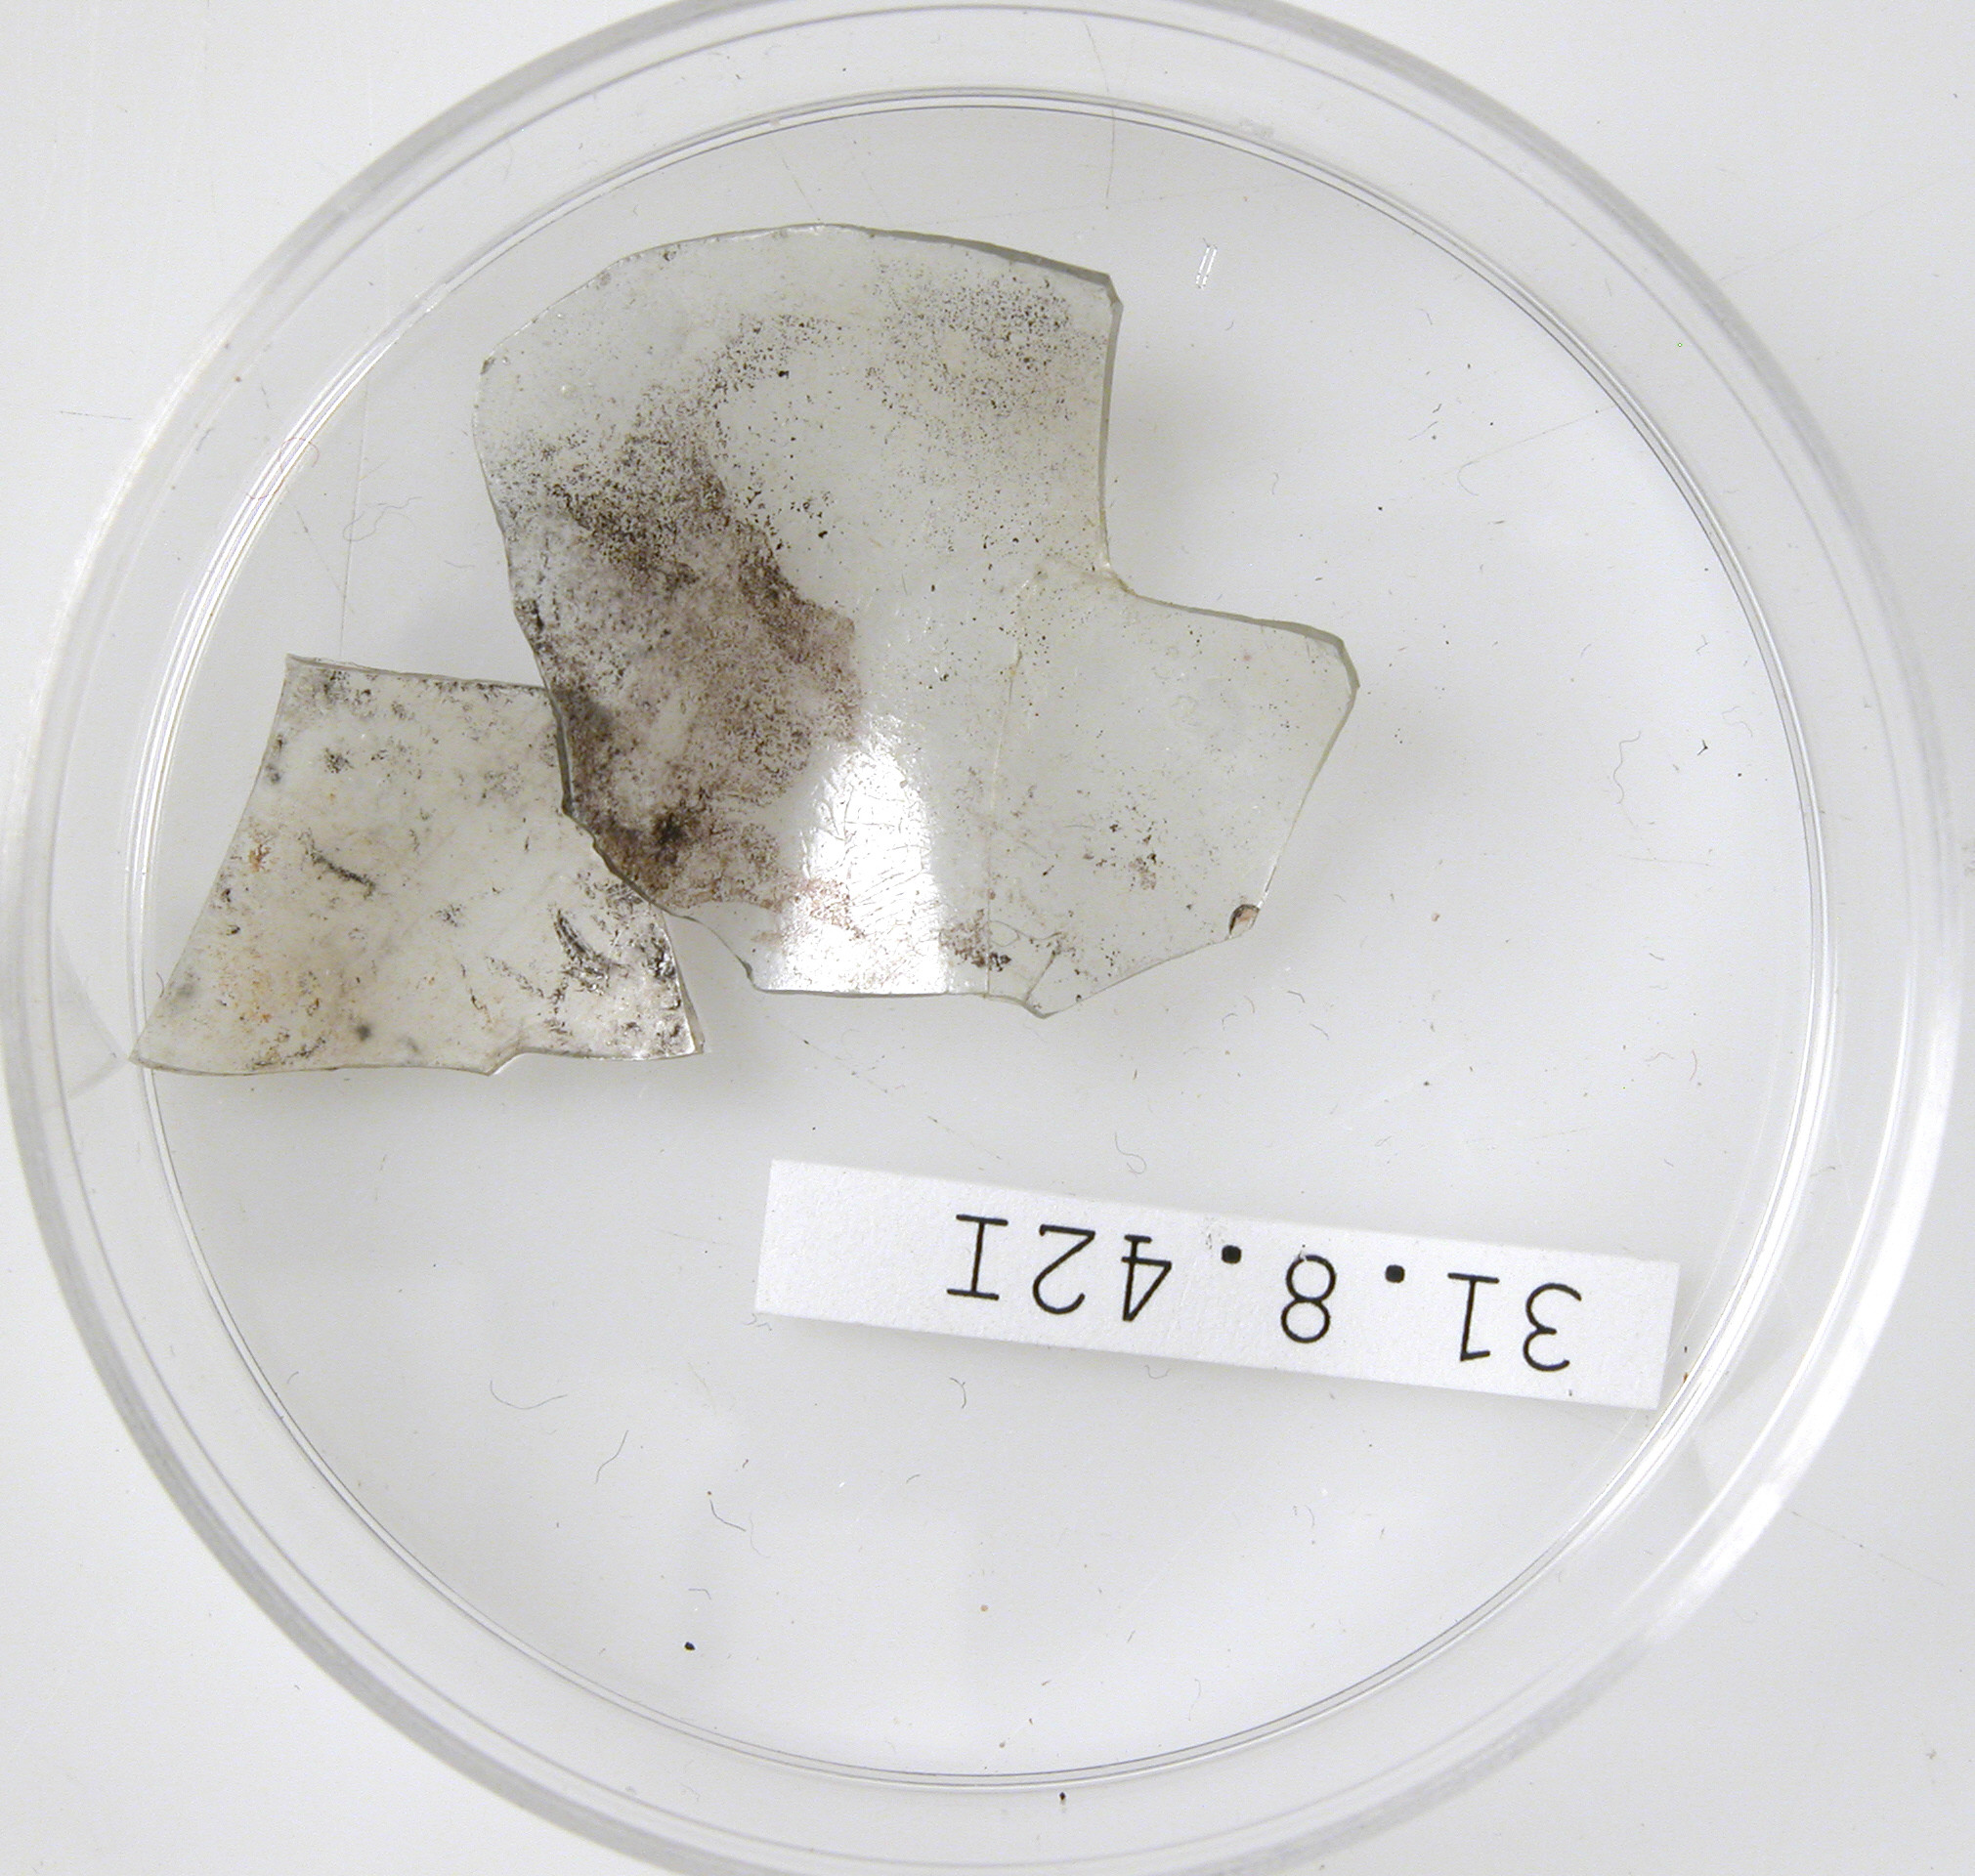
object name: fragment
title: Glass Fragments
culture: coptic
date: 301-400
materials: glass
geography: egypt